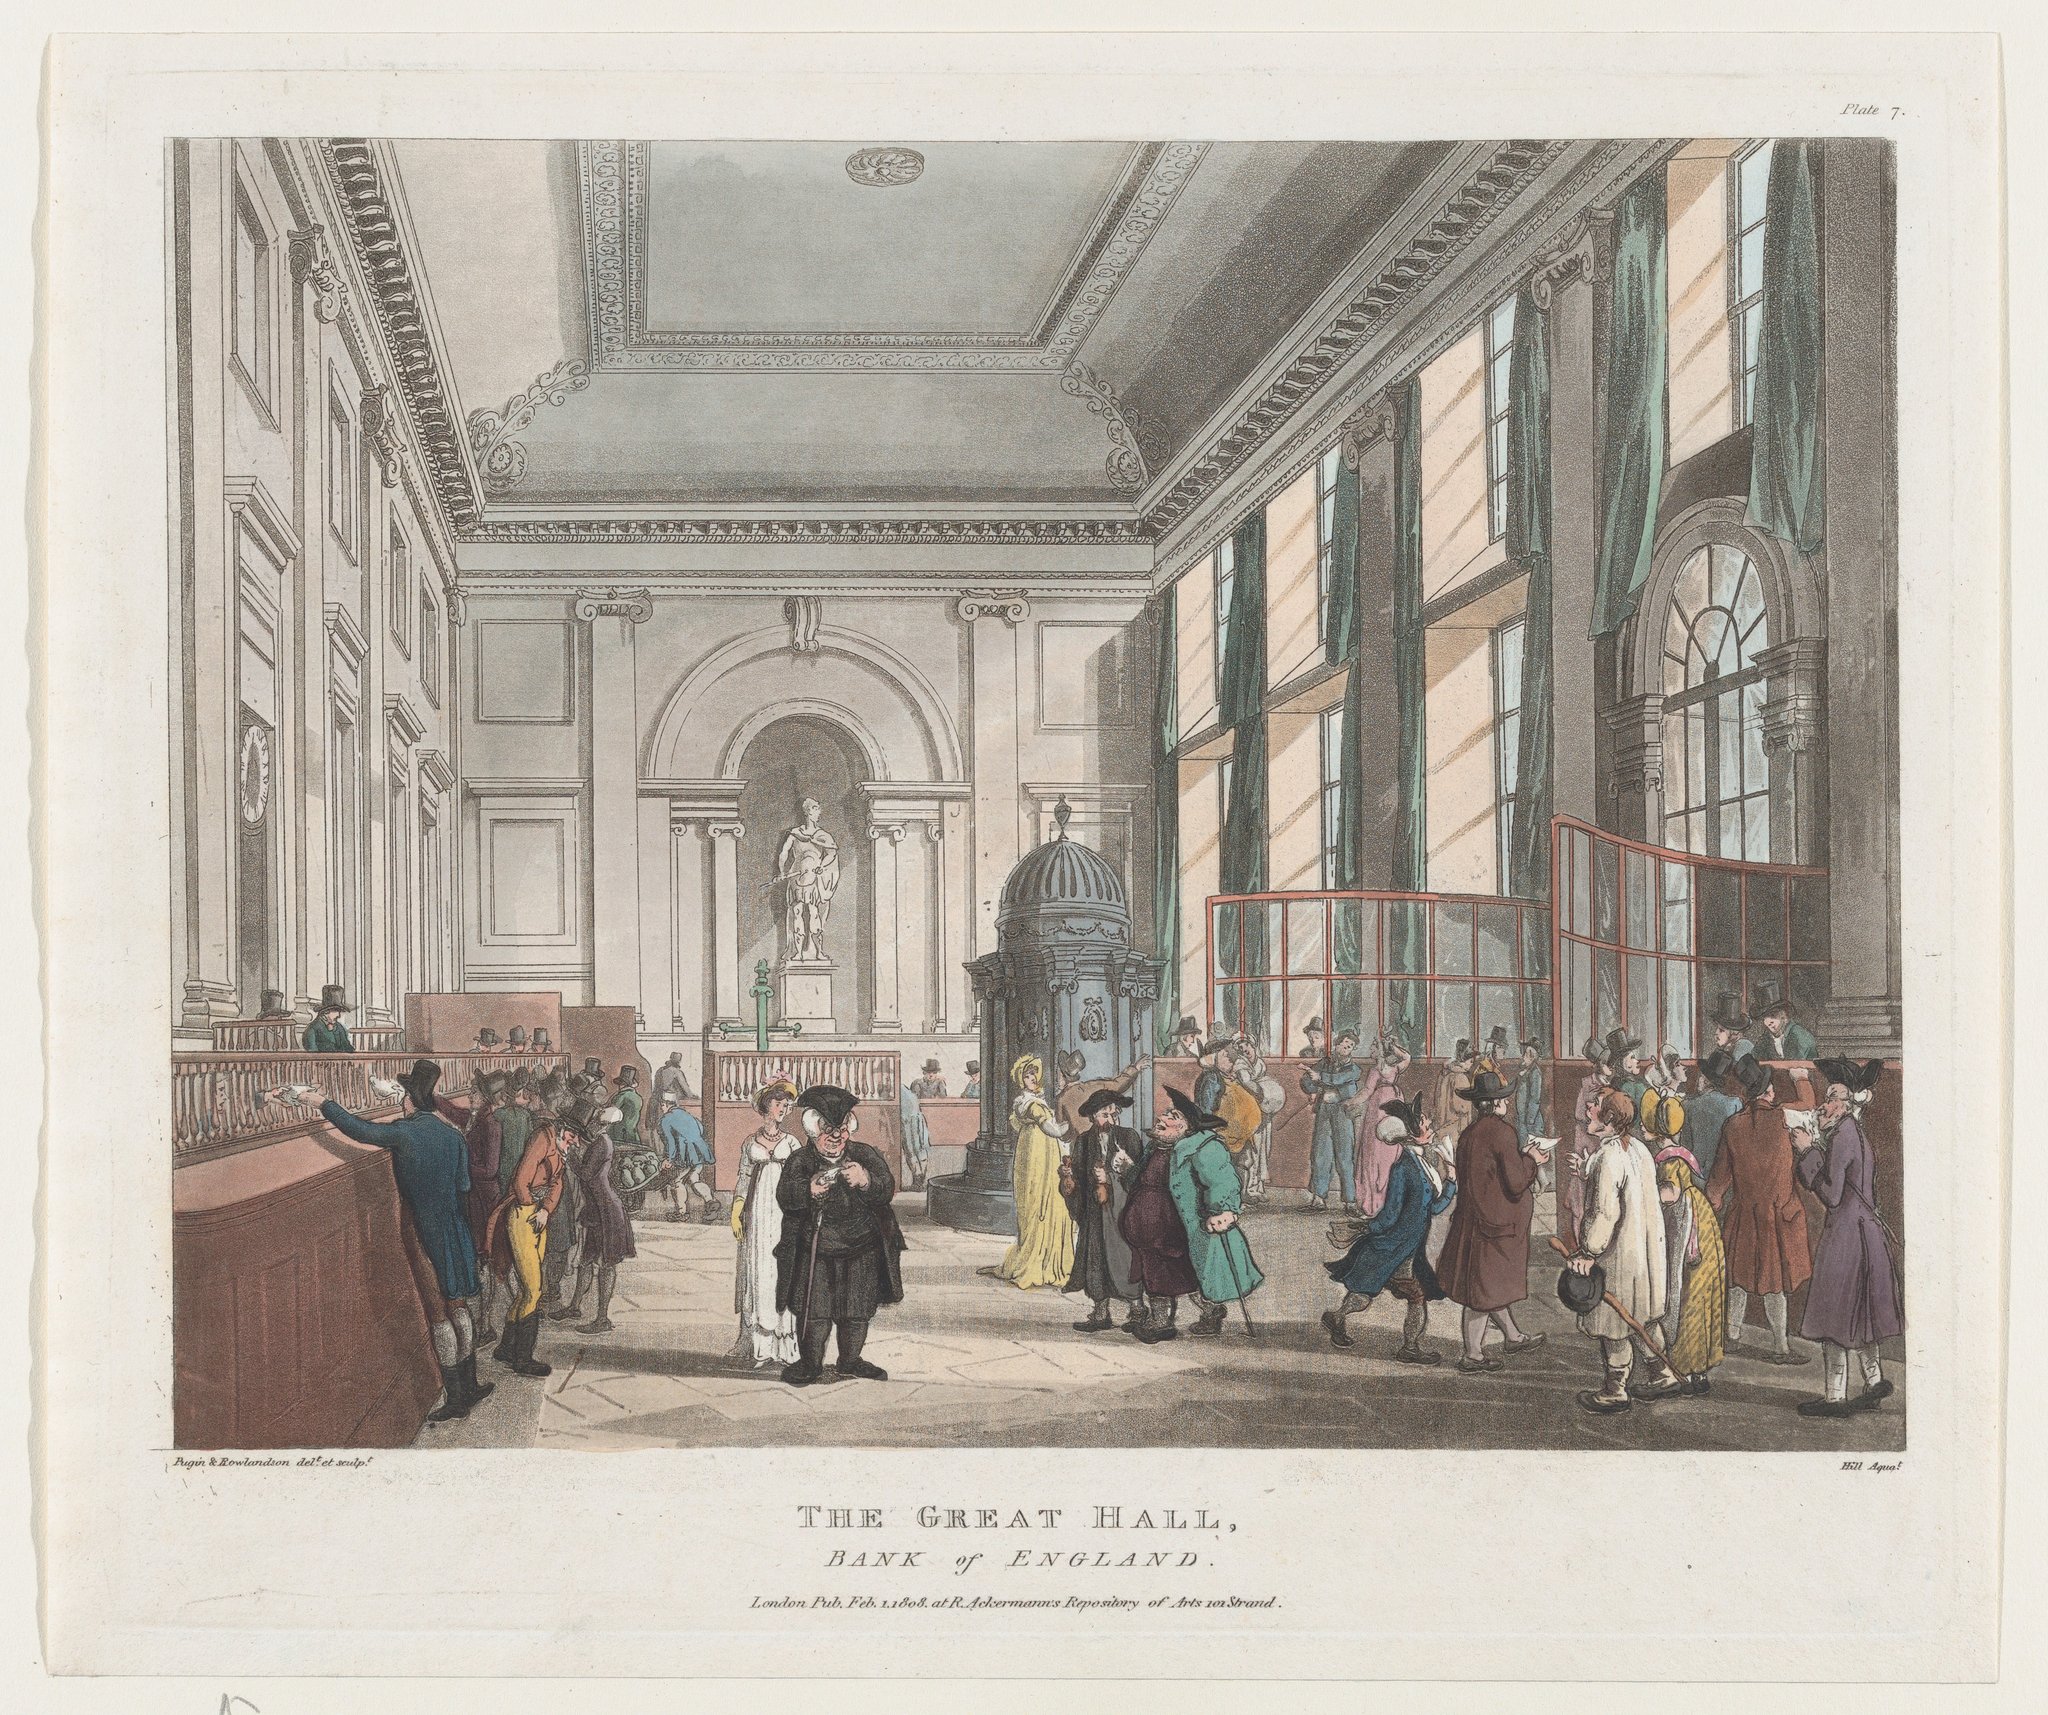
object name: print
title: The Great Hall, Bank of England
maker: thomas rowlandson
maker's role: artist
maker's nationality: british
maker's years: 1757-1827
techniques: aquatint, etching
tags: interiors,men,women